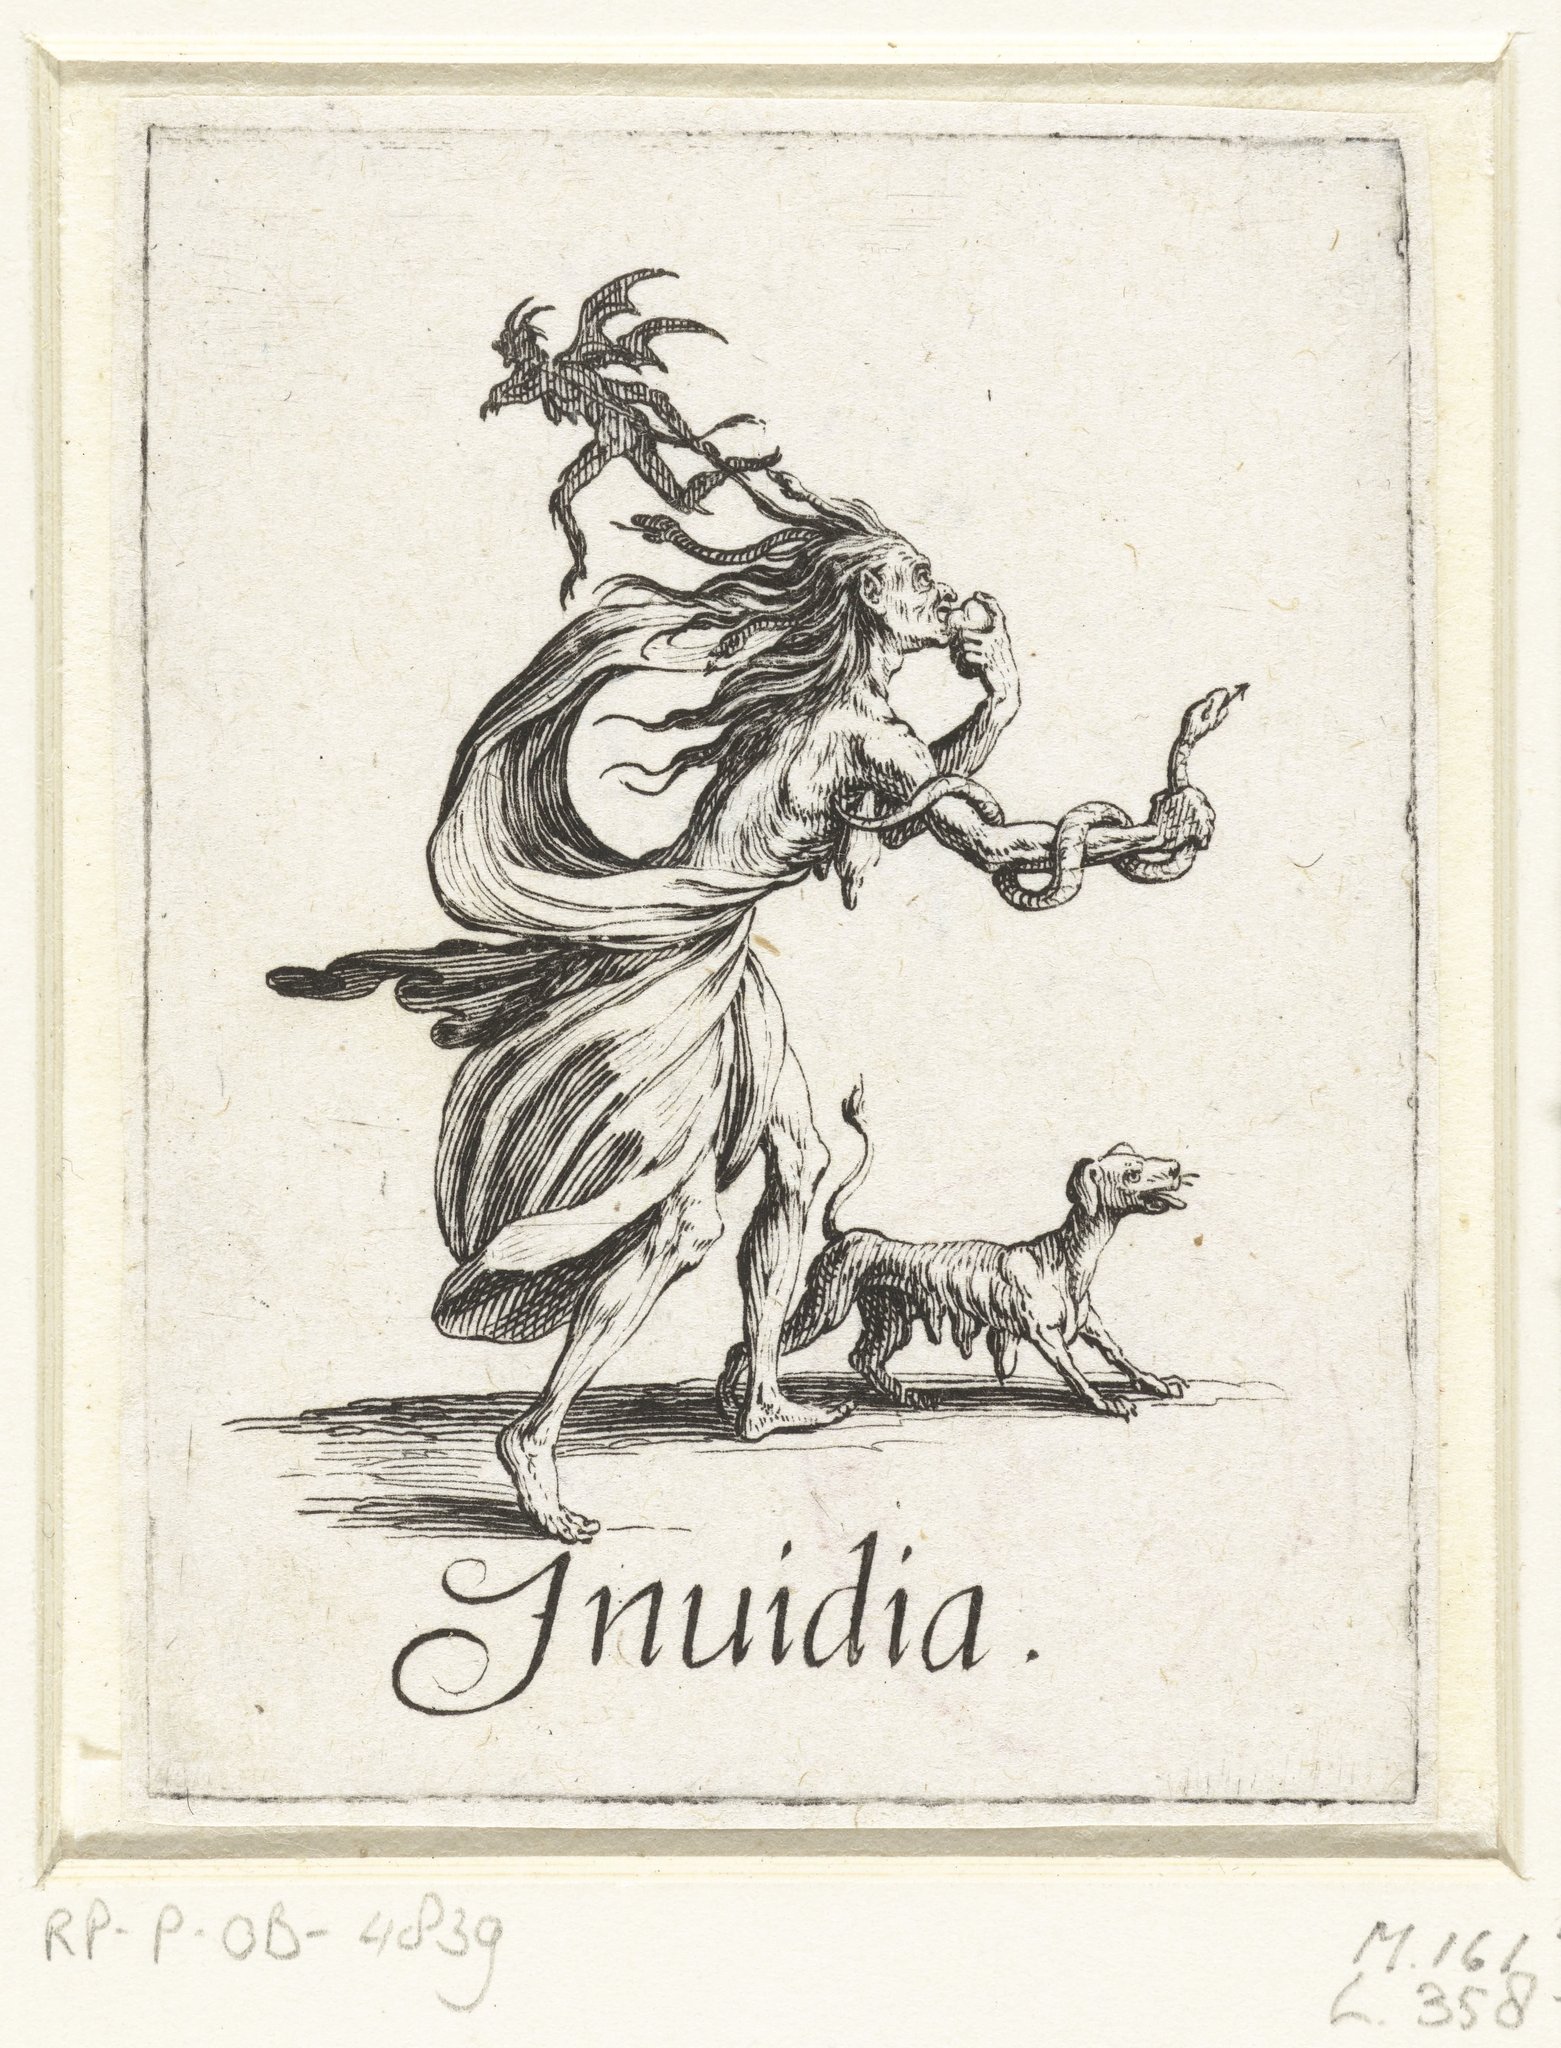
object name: print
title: Zeven hoofdzonden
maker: jacques callot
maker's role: draughtsman, print maker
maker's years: 1592-1635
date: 1618-1625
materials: paper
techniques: etching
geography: florence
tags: envy; 'invidia' (ripa) ~ personification of one of the seven deadly sins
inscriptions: collector's mark: Lugt 240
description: Een afzichtelijke oude vrouw met haar in de vorm van slangen en een slang in de hand eet een hart op. Naast haar staat een hond, boven haar vliegt een duiveltje. Onder de voorstelling de Latijnse term voor de zonde die de vrouw verbeeldt. Deze prent is onderdeel van een serie van zeven prenten waarop de hoofdzonden als allegorische figuren zijn weergegeven.